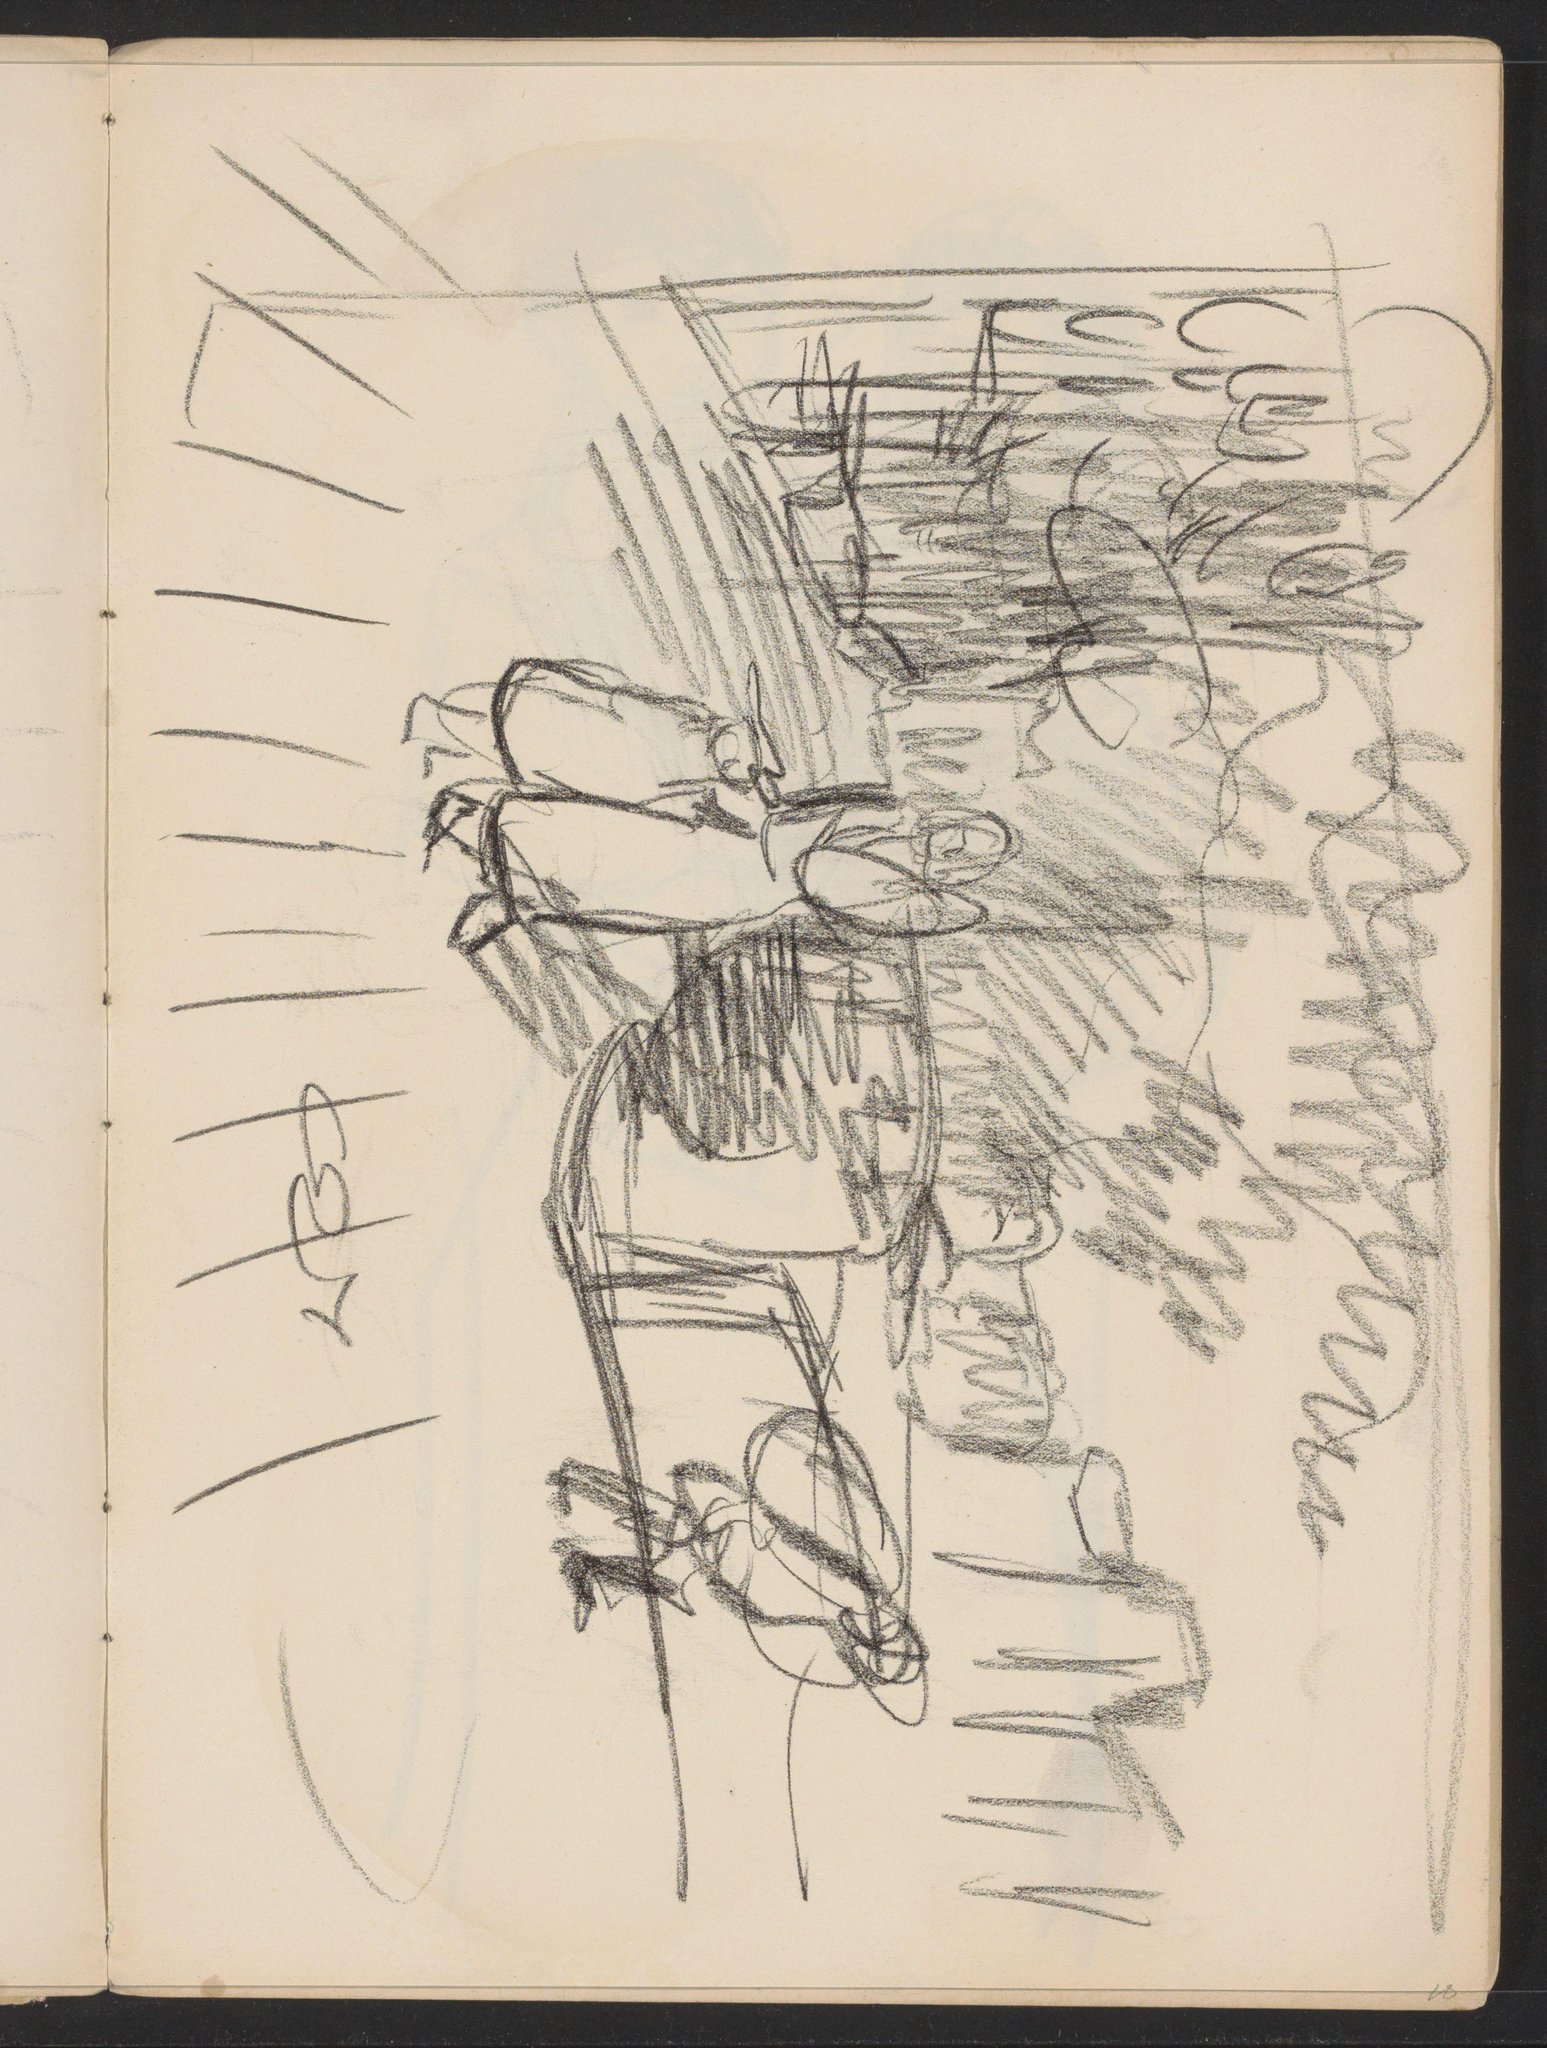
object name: sketchbook leaf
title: Voorbijgangers, waarschijnlijk op de Herengracht te Amsterdam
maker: isaac israels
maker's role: draughtsman, painter, print maker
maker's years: 1865-1934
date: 1886-1934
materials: chalk, paper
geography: amsterdam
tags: adult woman, child, carrying something in basket, bag, rucksack, etc., canals, waters (in city) (+ city(-scape) with figures, staffage)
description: Mogelijk ter hoogte van de brug over de Brouwersgracht. Onder andere een sjouwer met een zak over zijn schouder en een vrouw met twee kinderen. Blad 18 recto uit schetsboek LXVI-B met 25 bladen.